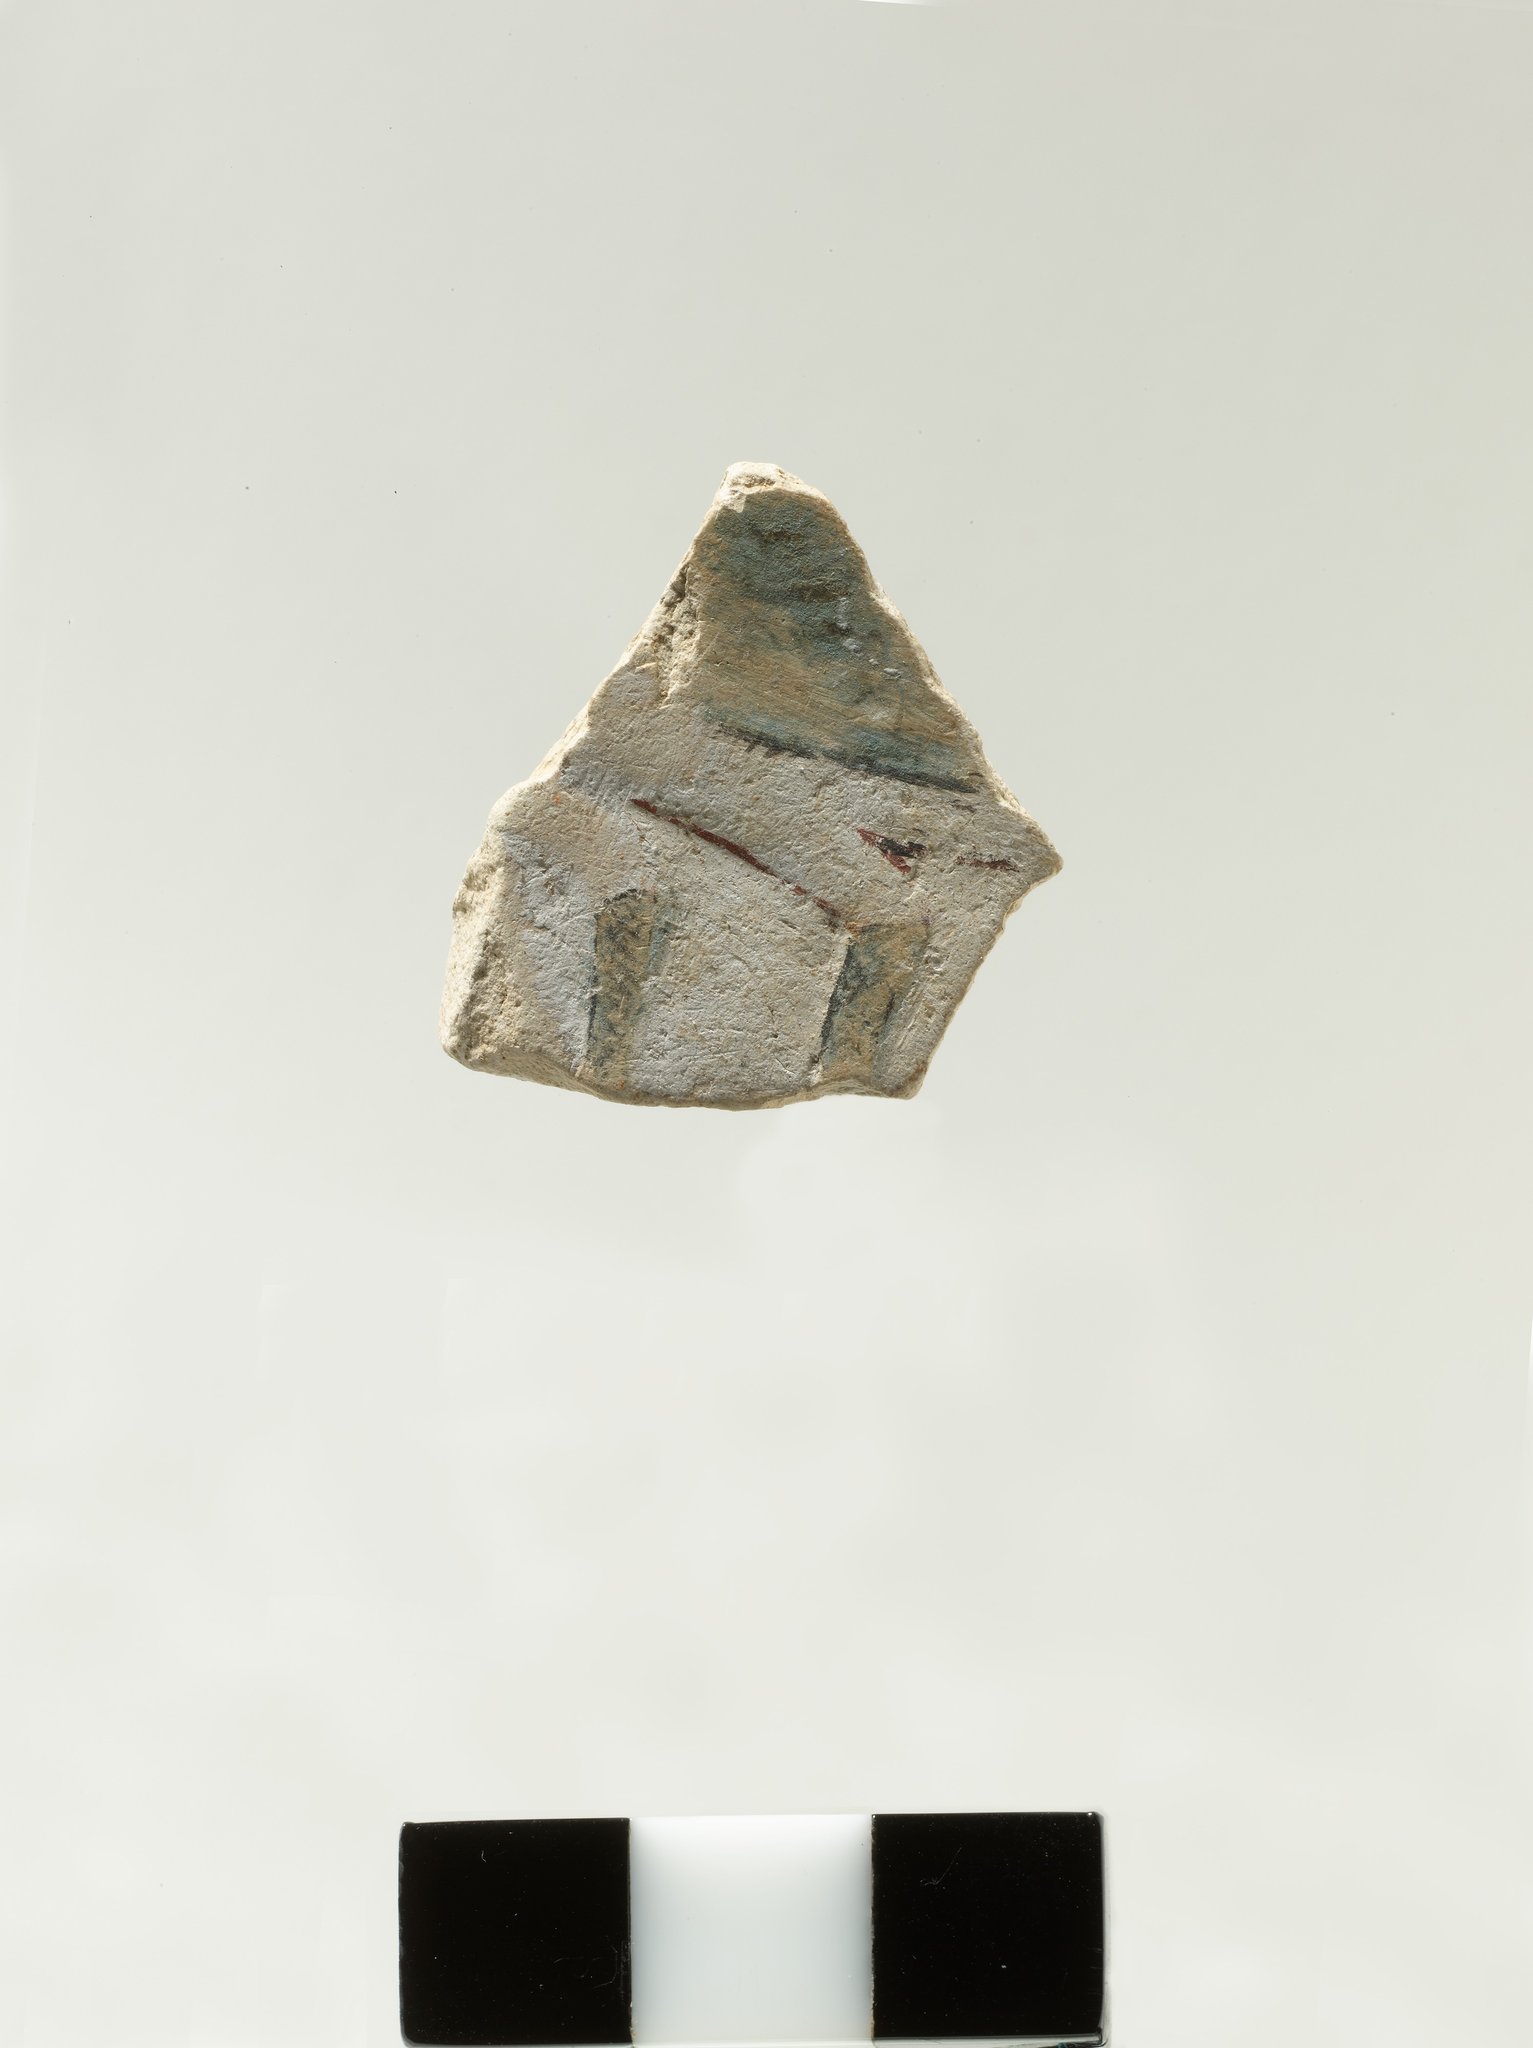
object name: relief fragment, tomb of meketre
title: Relief fragment from the tomb of Meketre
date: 1981-1975 BCE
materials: limestone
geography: egypt